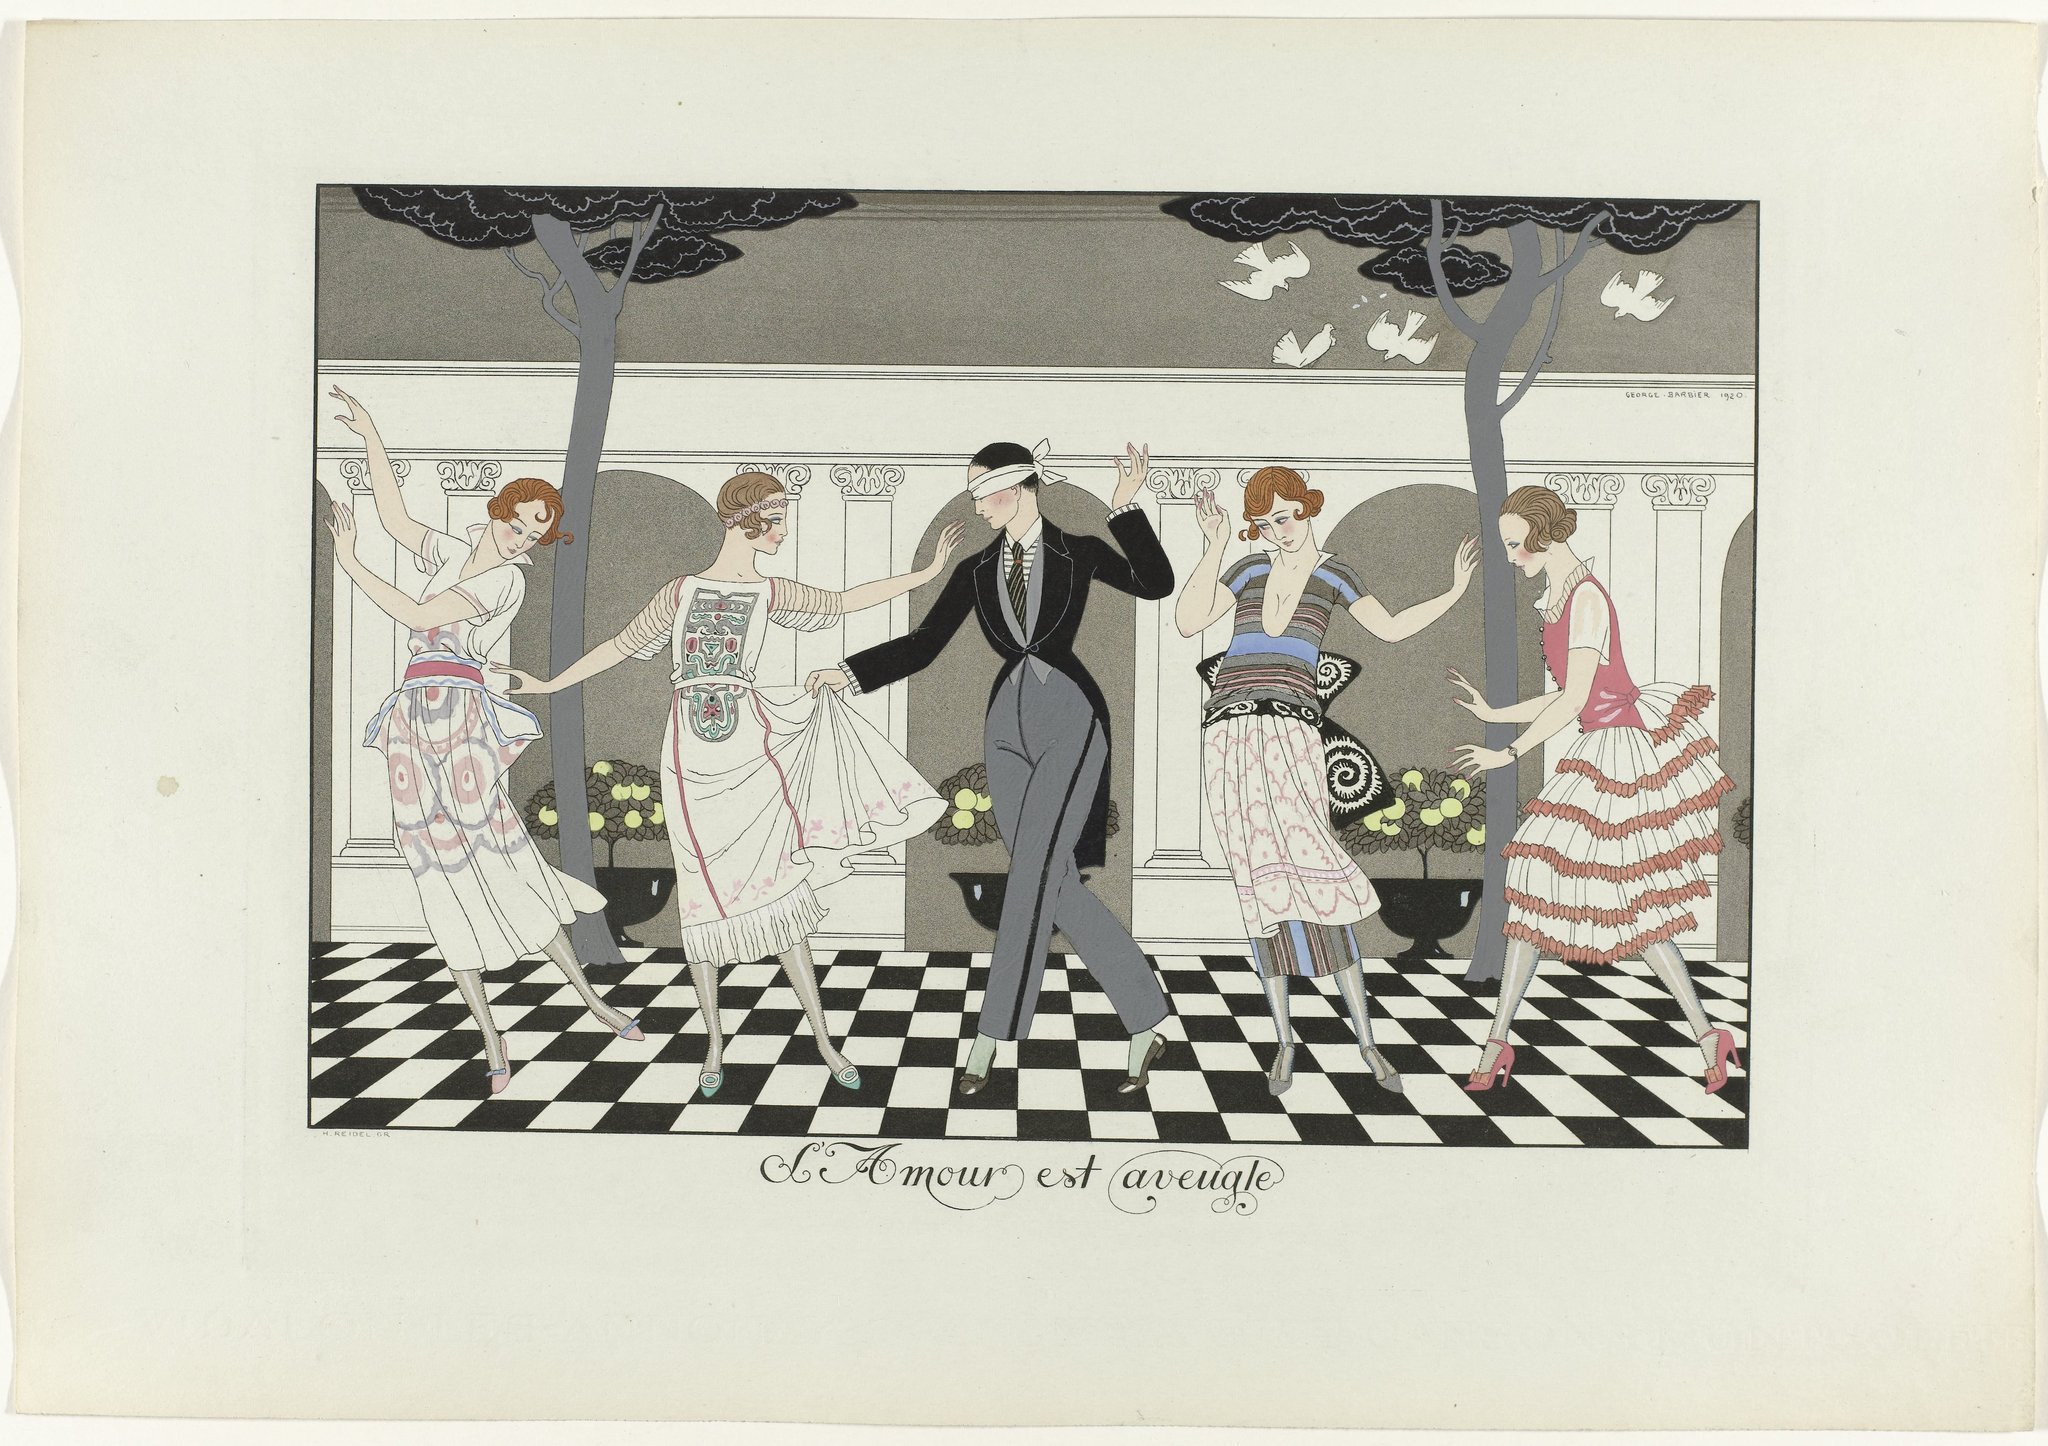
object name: fashion print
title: Le Bonheur du Jour ou Les Graces à la Mode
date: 1920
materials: paper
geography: paris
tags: fashion plates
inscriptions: date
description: Uit serie Le Bonheur du Jour ou Les Graces à la Mode.